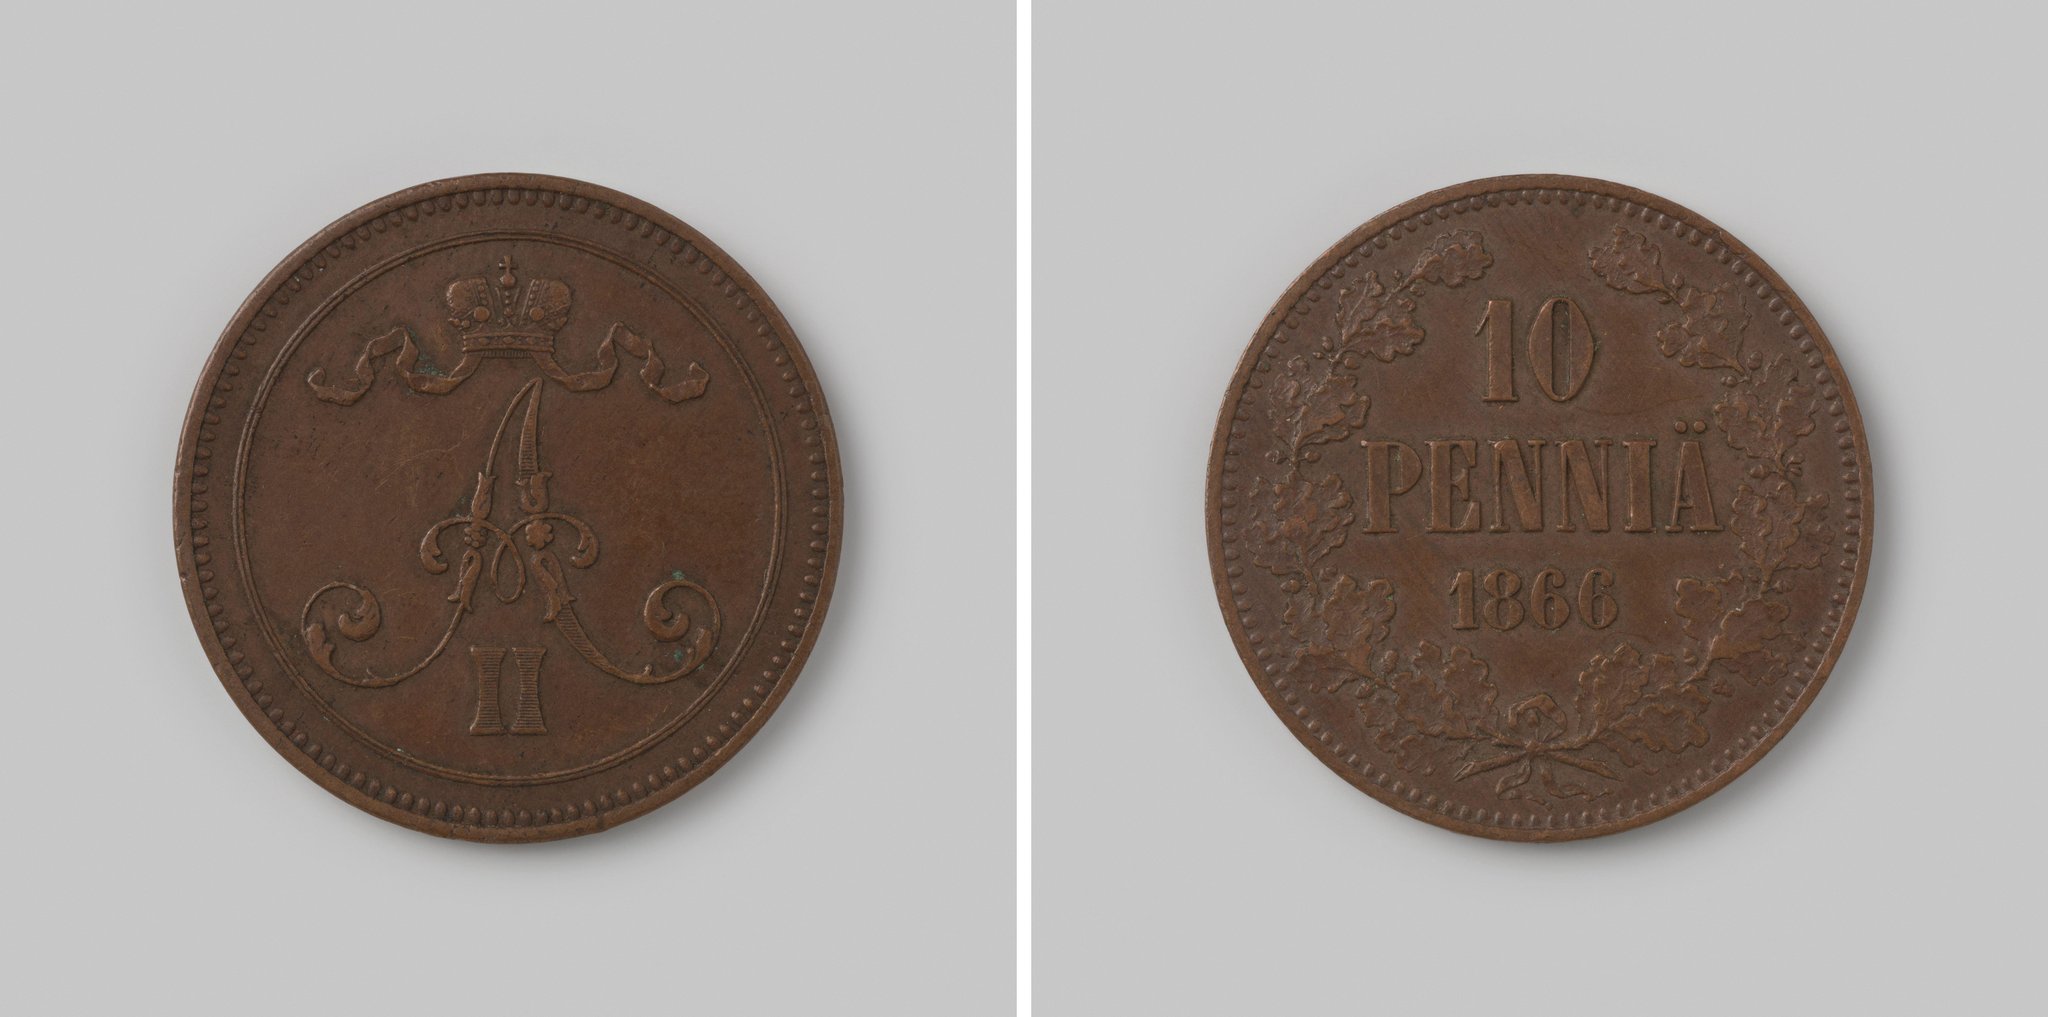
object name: coin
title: 10 penniä uit Finland van tsaar Alexander II, 1866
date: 1866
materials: copper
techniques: striking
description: Koperen munt. Voorzijde: monogram van Alexander II. Daarboven een kroon met lint. Keerzijde: tussen twee samengebonden takken in twee regels waarde-aanduiding, waaronder jaartal. Gladde rand.